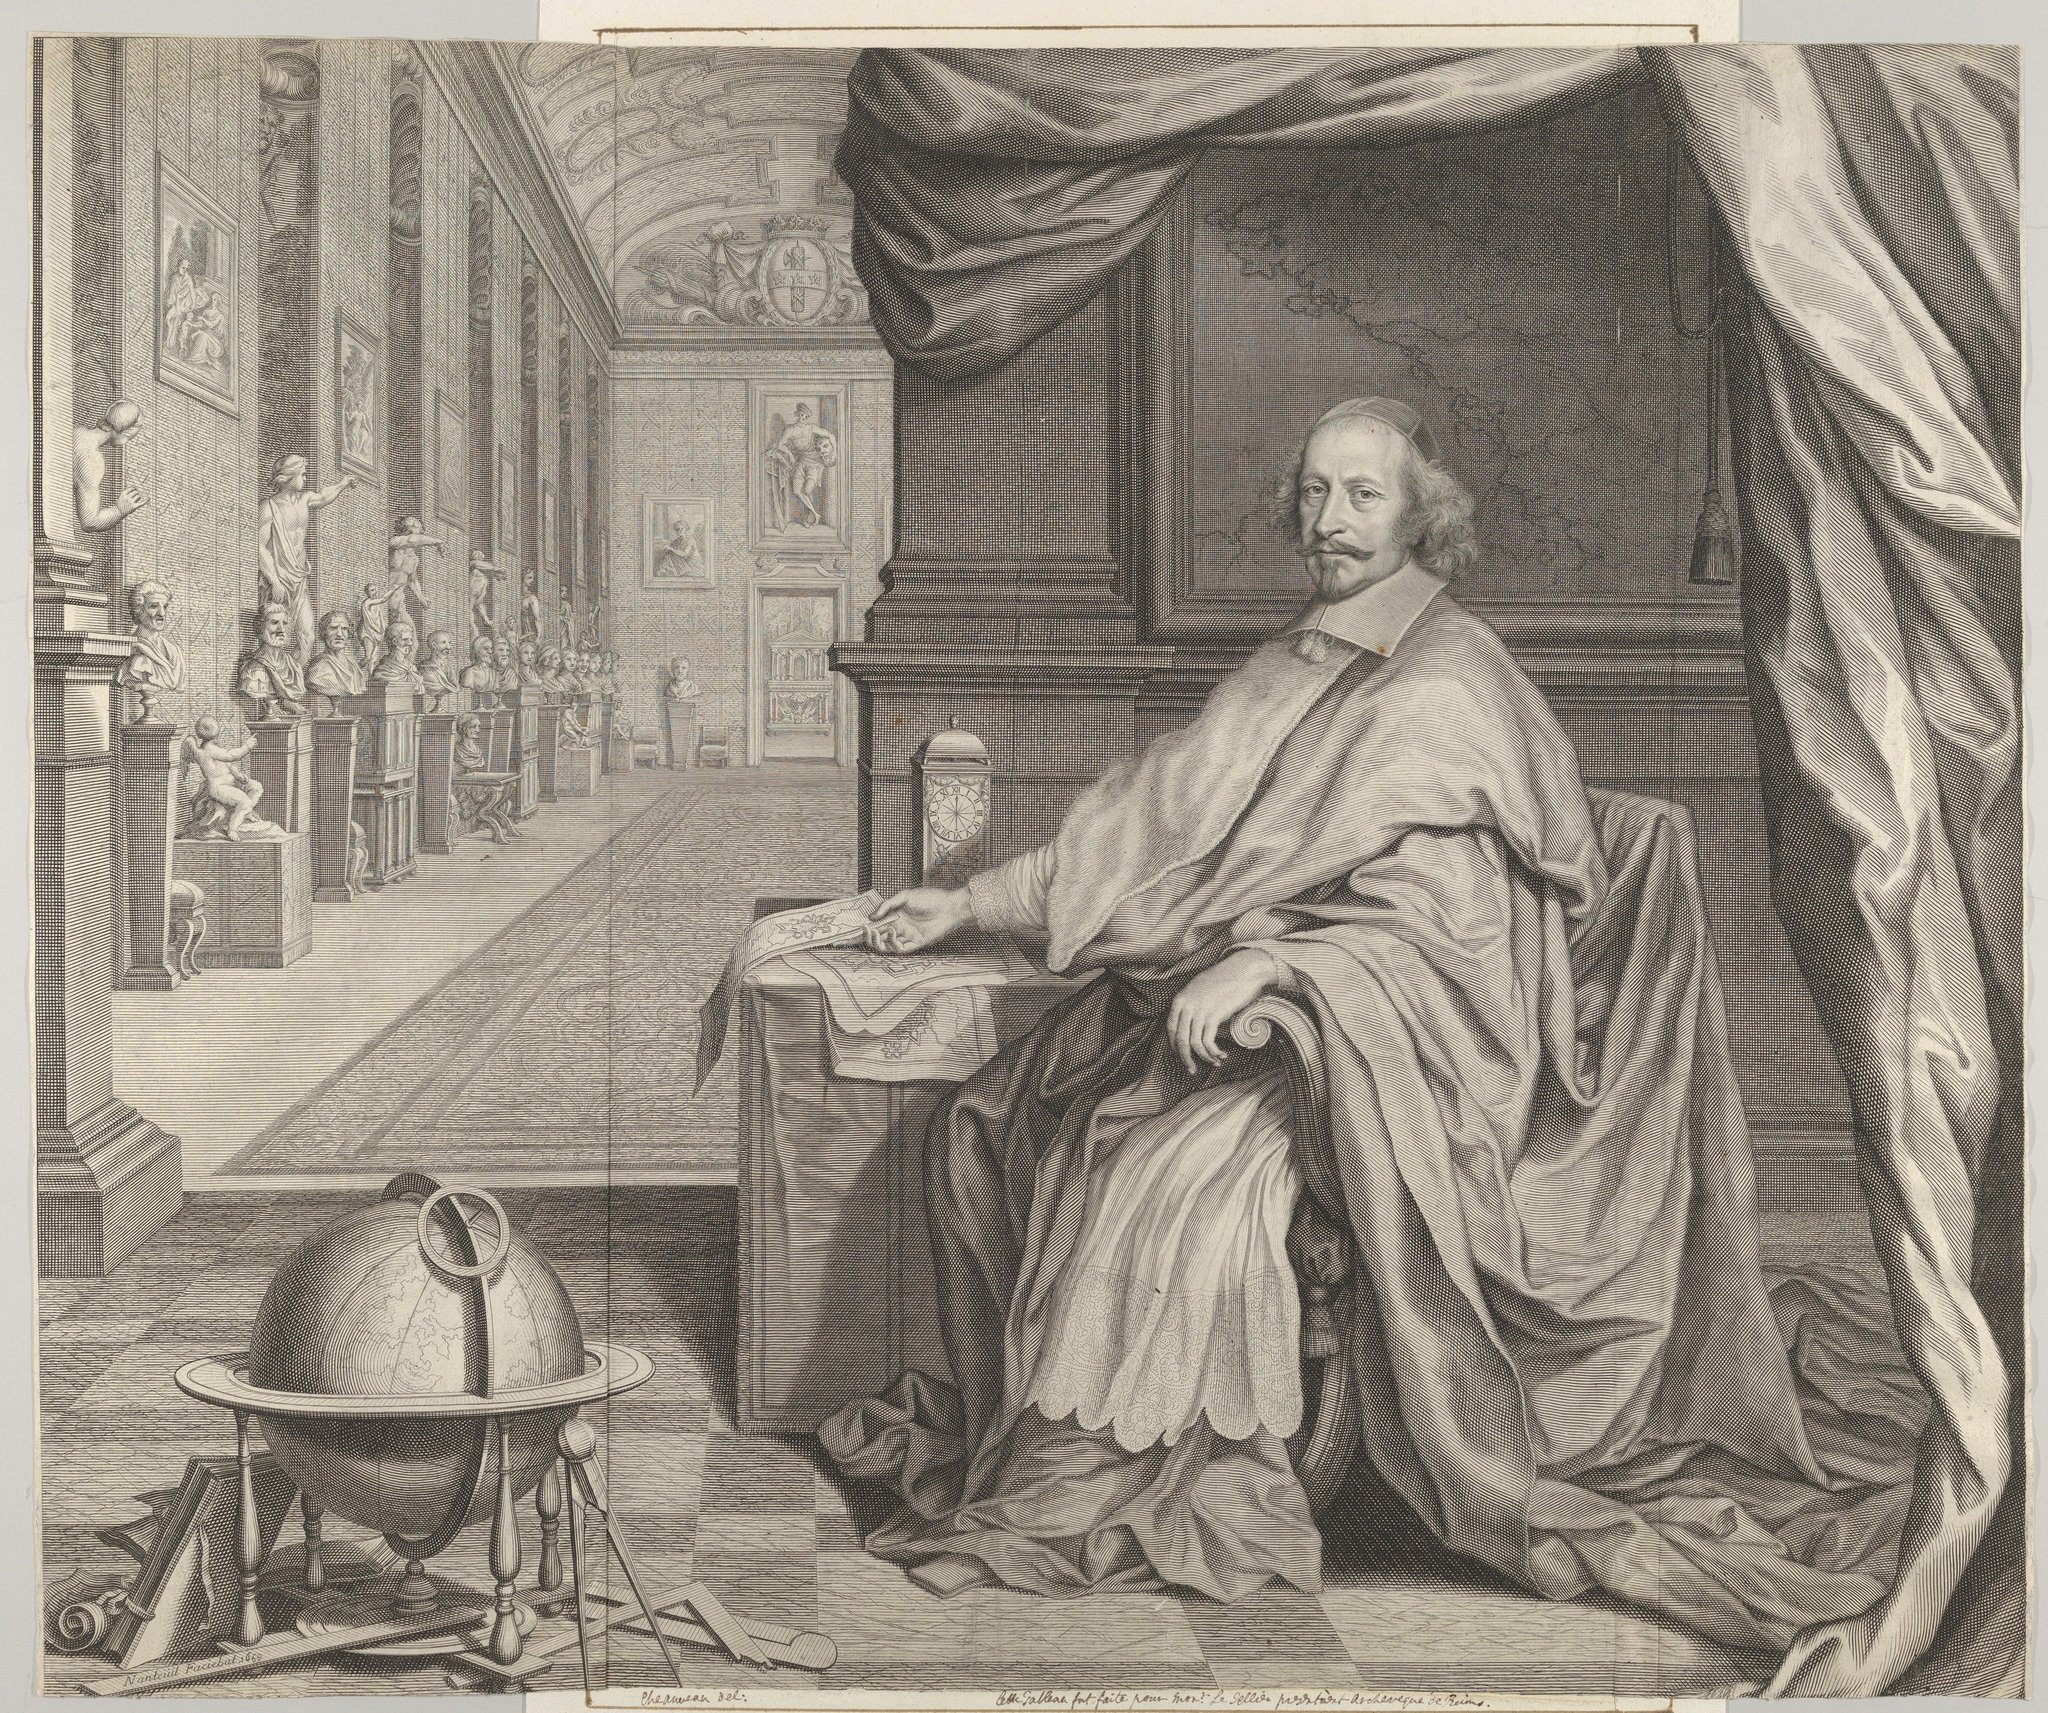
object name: print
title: Cardinal Jules Mazarin Seated Within the Gallery of his Palace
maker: robert nanteuil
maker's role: artist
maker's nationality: french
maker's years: 1623-1678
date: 1659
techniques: engraving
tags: palaces,interiors,men,globes